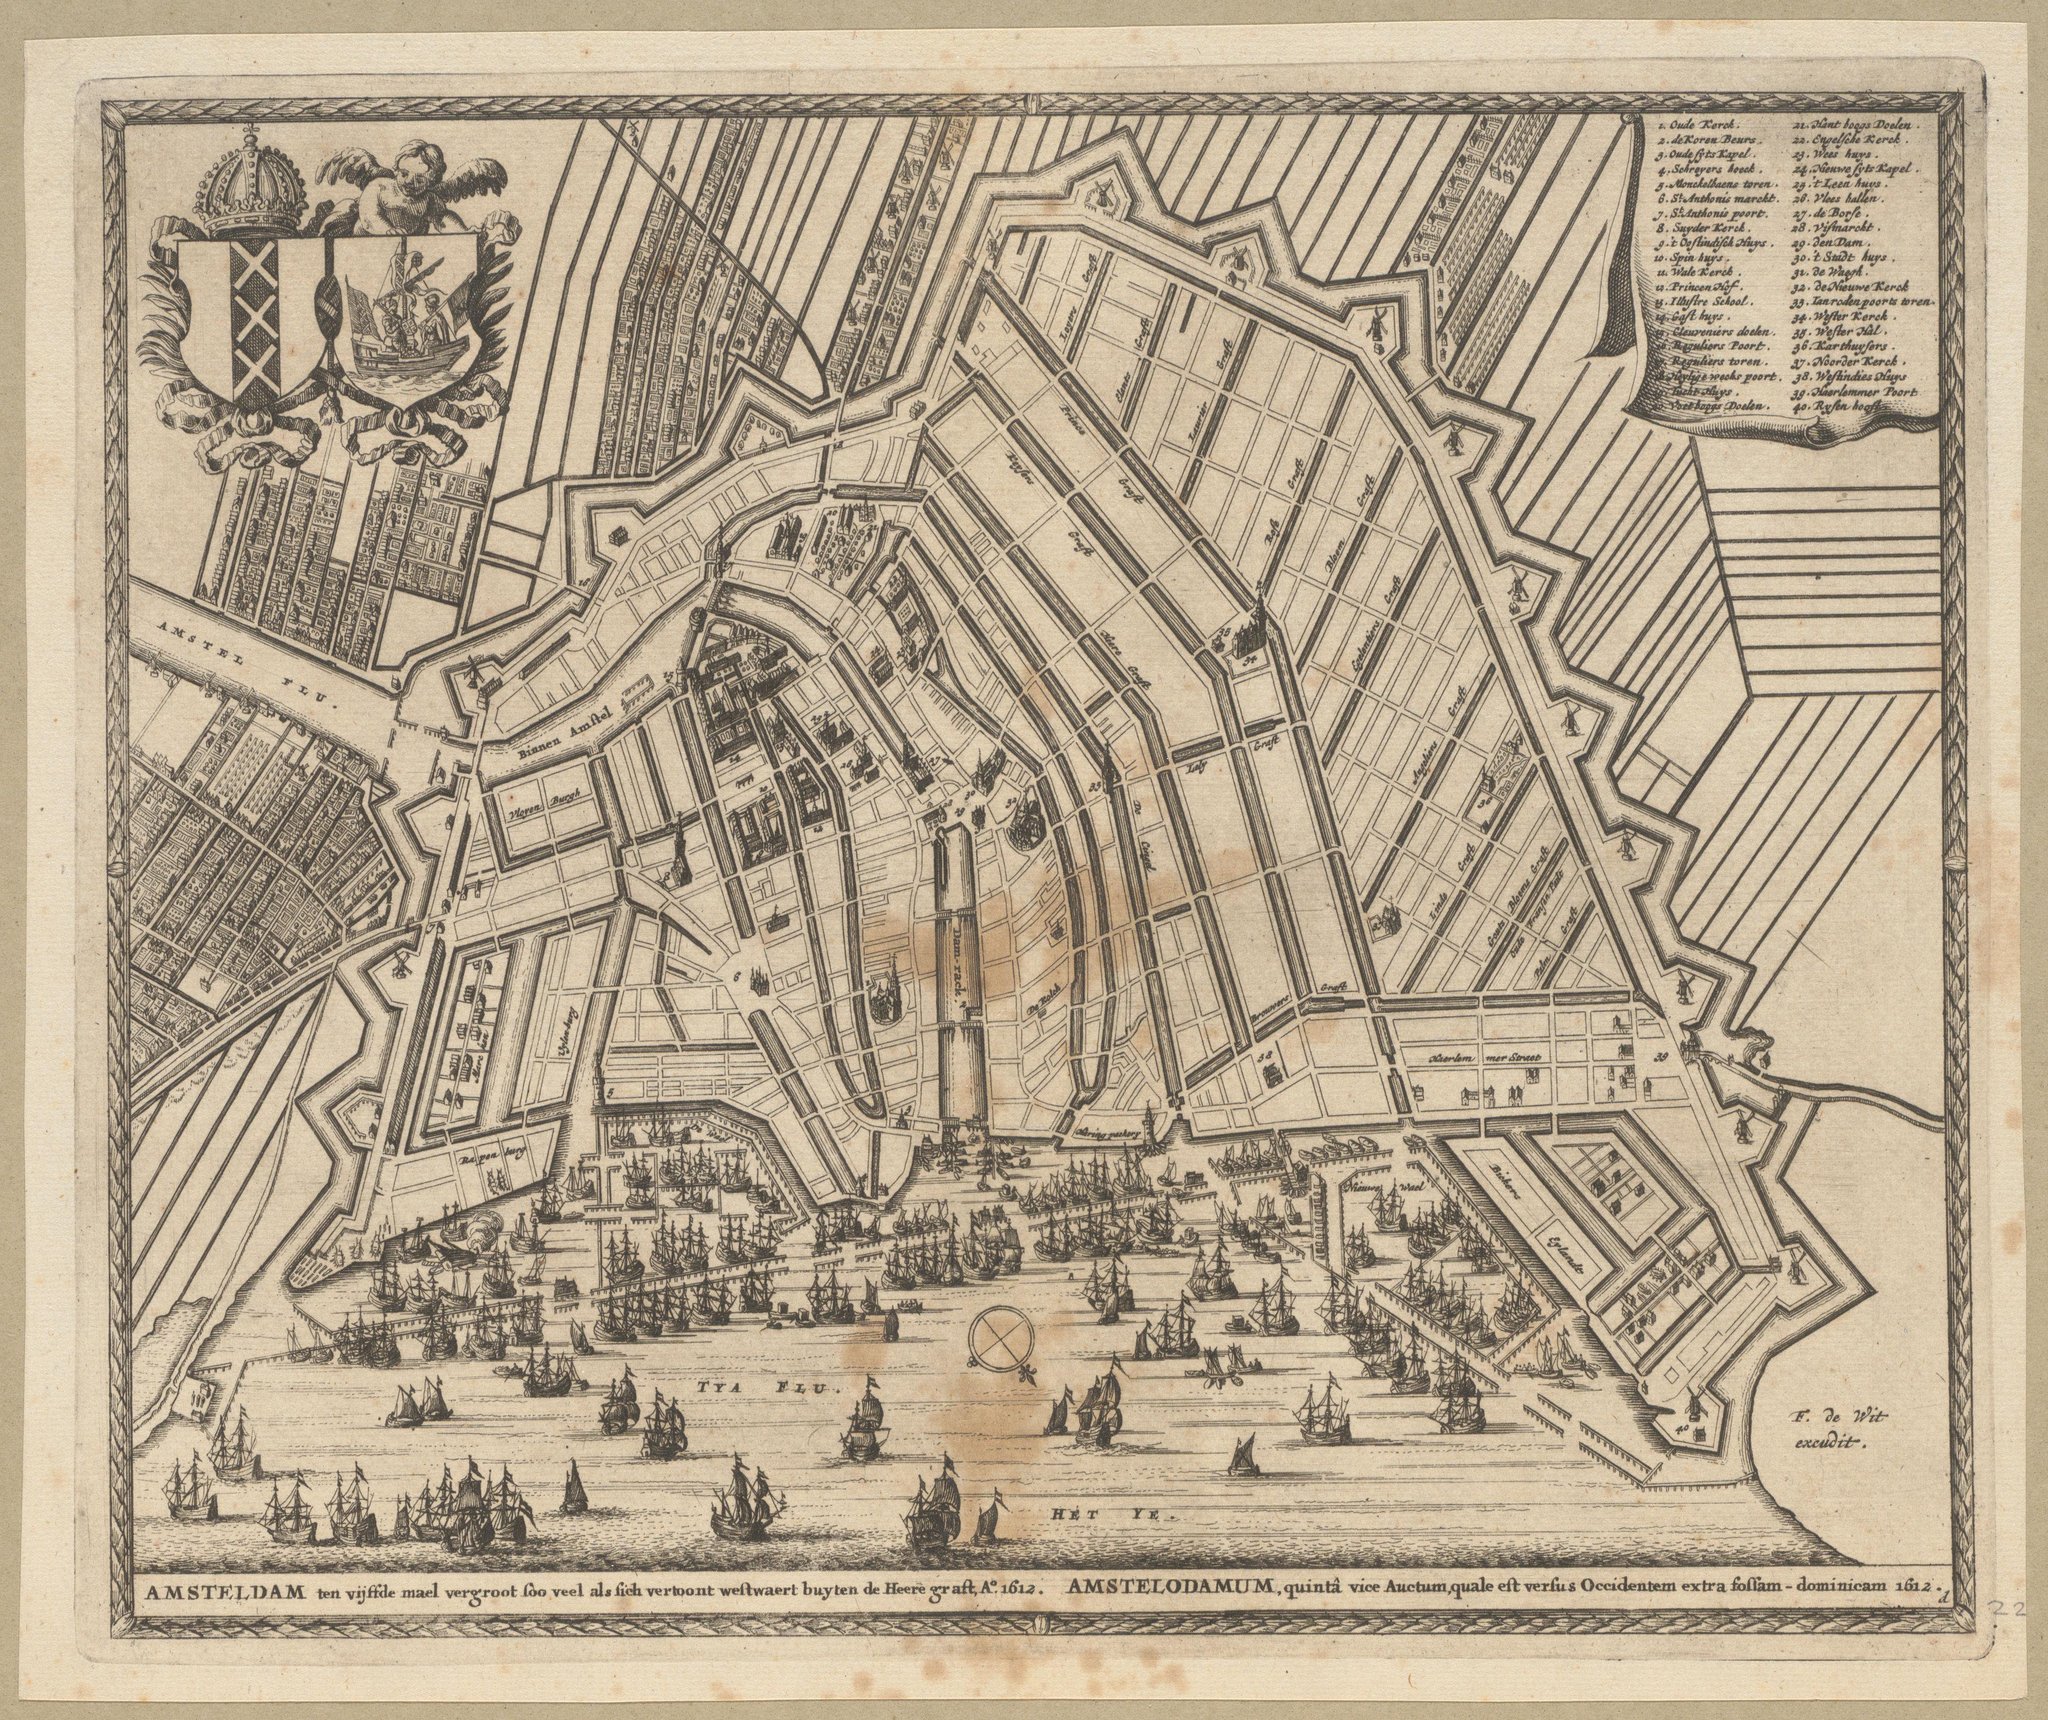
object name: print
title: Plattegrond van Amsterdam, 1612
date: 1671-1680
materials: paper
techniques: engraving, etching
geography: amsterdam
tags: coat of arms (as symbol of the state, etc.) (+ city; municipal), seal (as symbol of the state, etc.) (+ city; municipal), maps of cities, amsterdam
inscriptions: collector's mark: Lugt 1641b